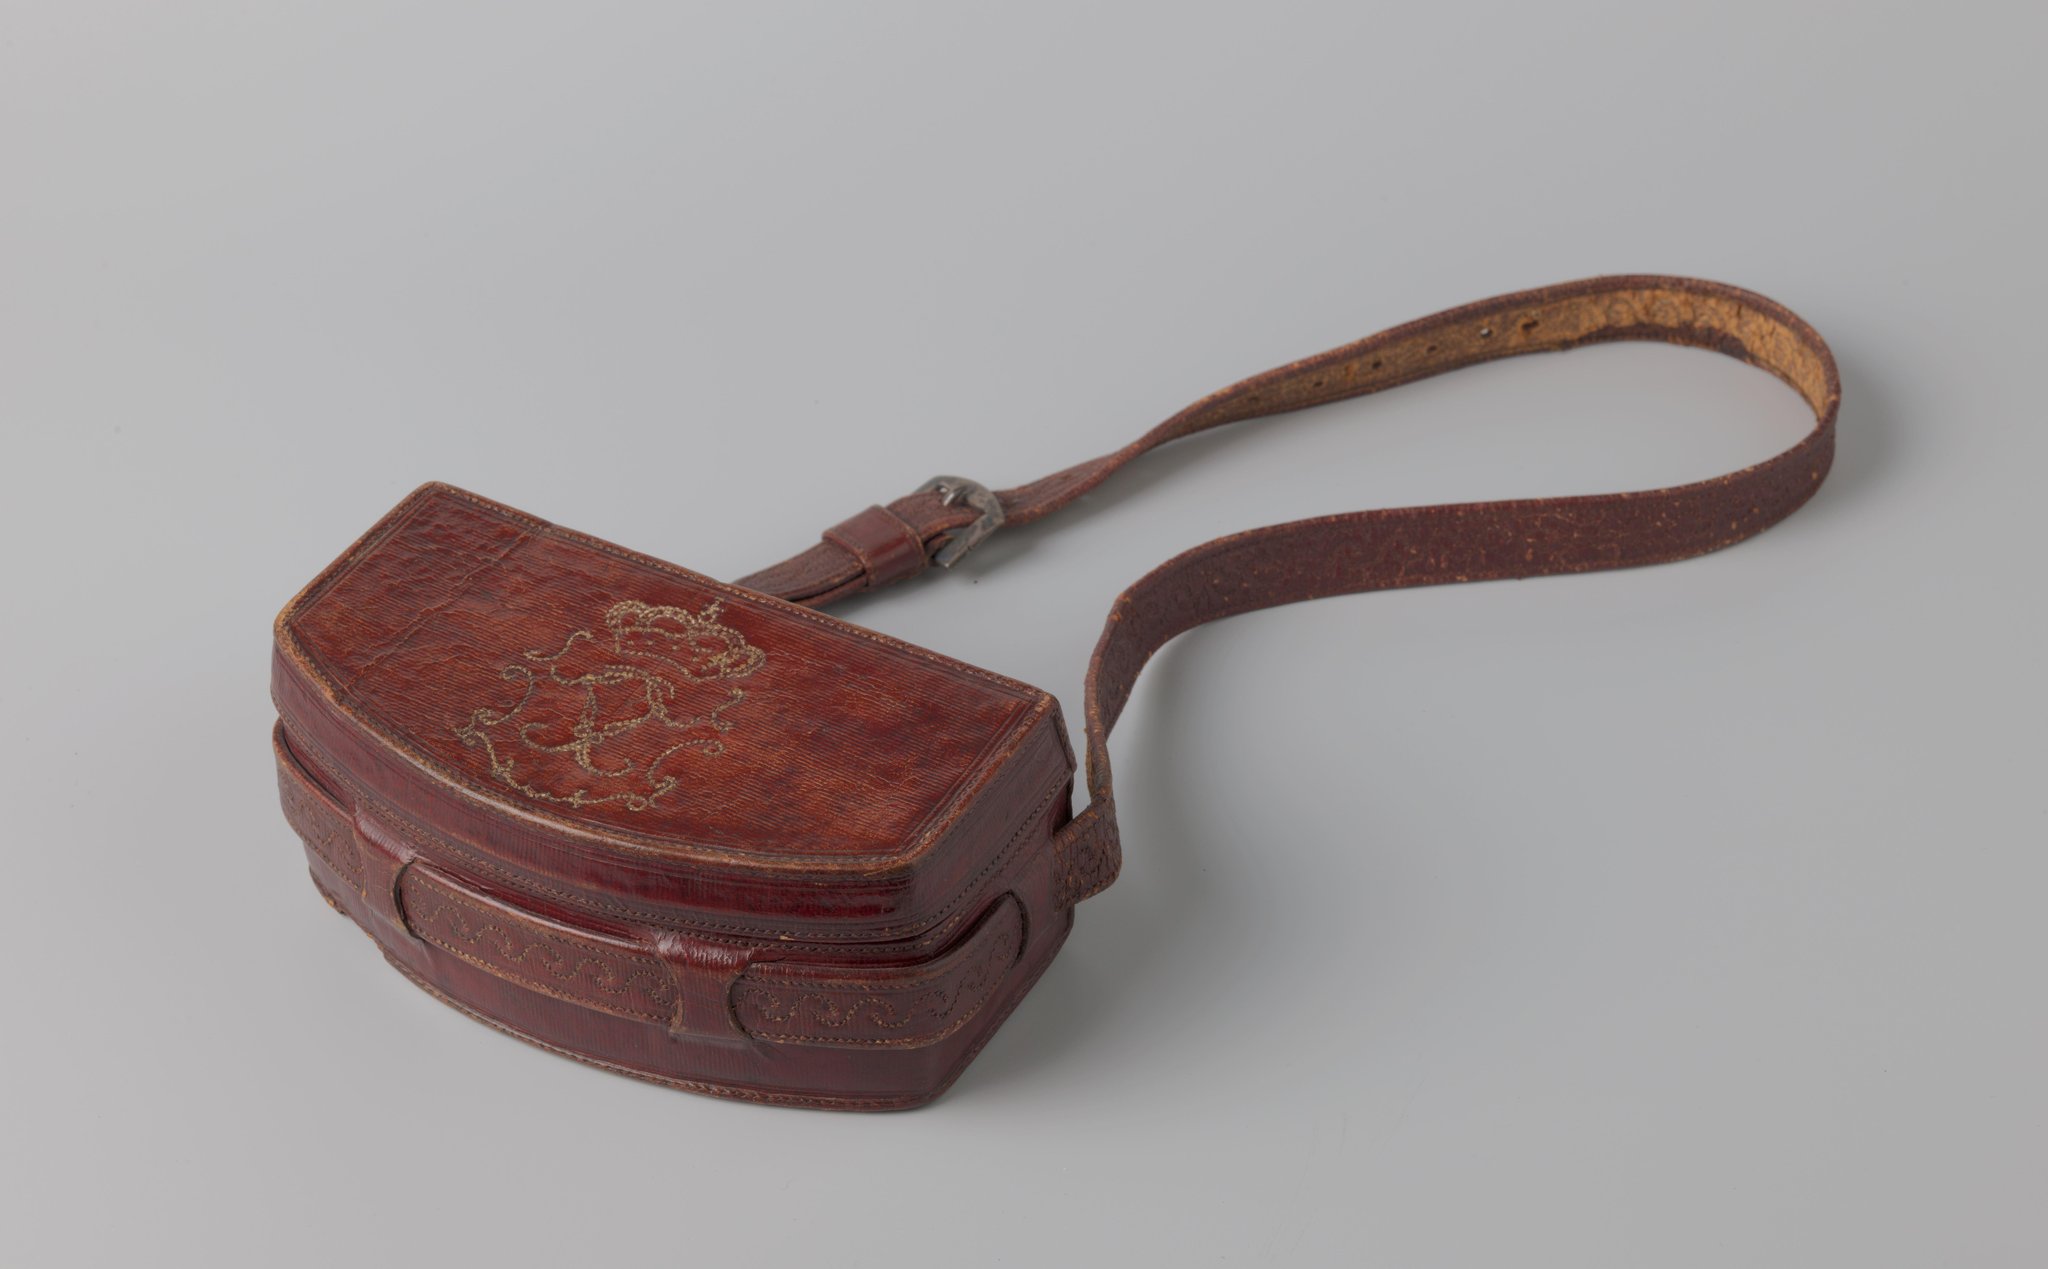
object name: bag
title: Munitietas van rood leer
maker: Anonymous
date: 1700-1800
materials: copper, leather, steel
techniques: cutting, forging, sewing, tanning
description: Rechthoekige tas met bolvormige bodem. Deksel scharniert met tas. Riem met ijzeren gesp zit door leren lussen aan tas. Riem heeft sierstiksel in de vorm van S-vormige motieven die elkaar half overlappen. Op het deksel is een gestileerd gekroond wapen ingeslagen (koper). Volgens beschrijving uit 1803 'een tasje tot gezwinde pijpjes van rood maroquin leder met zijde gestikt'.